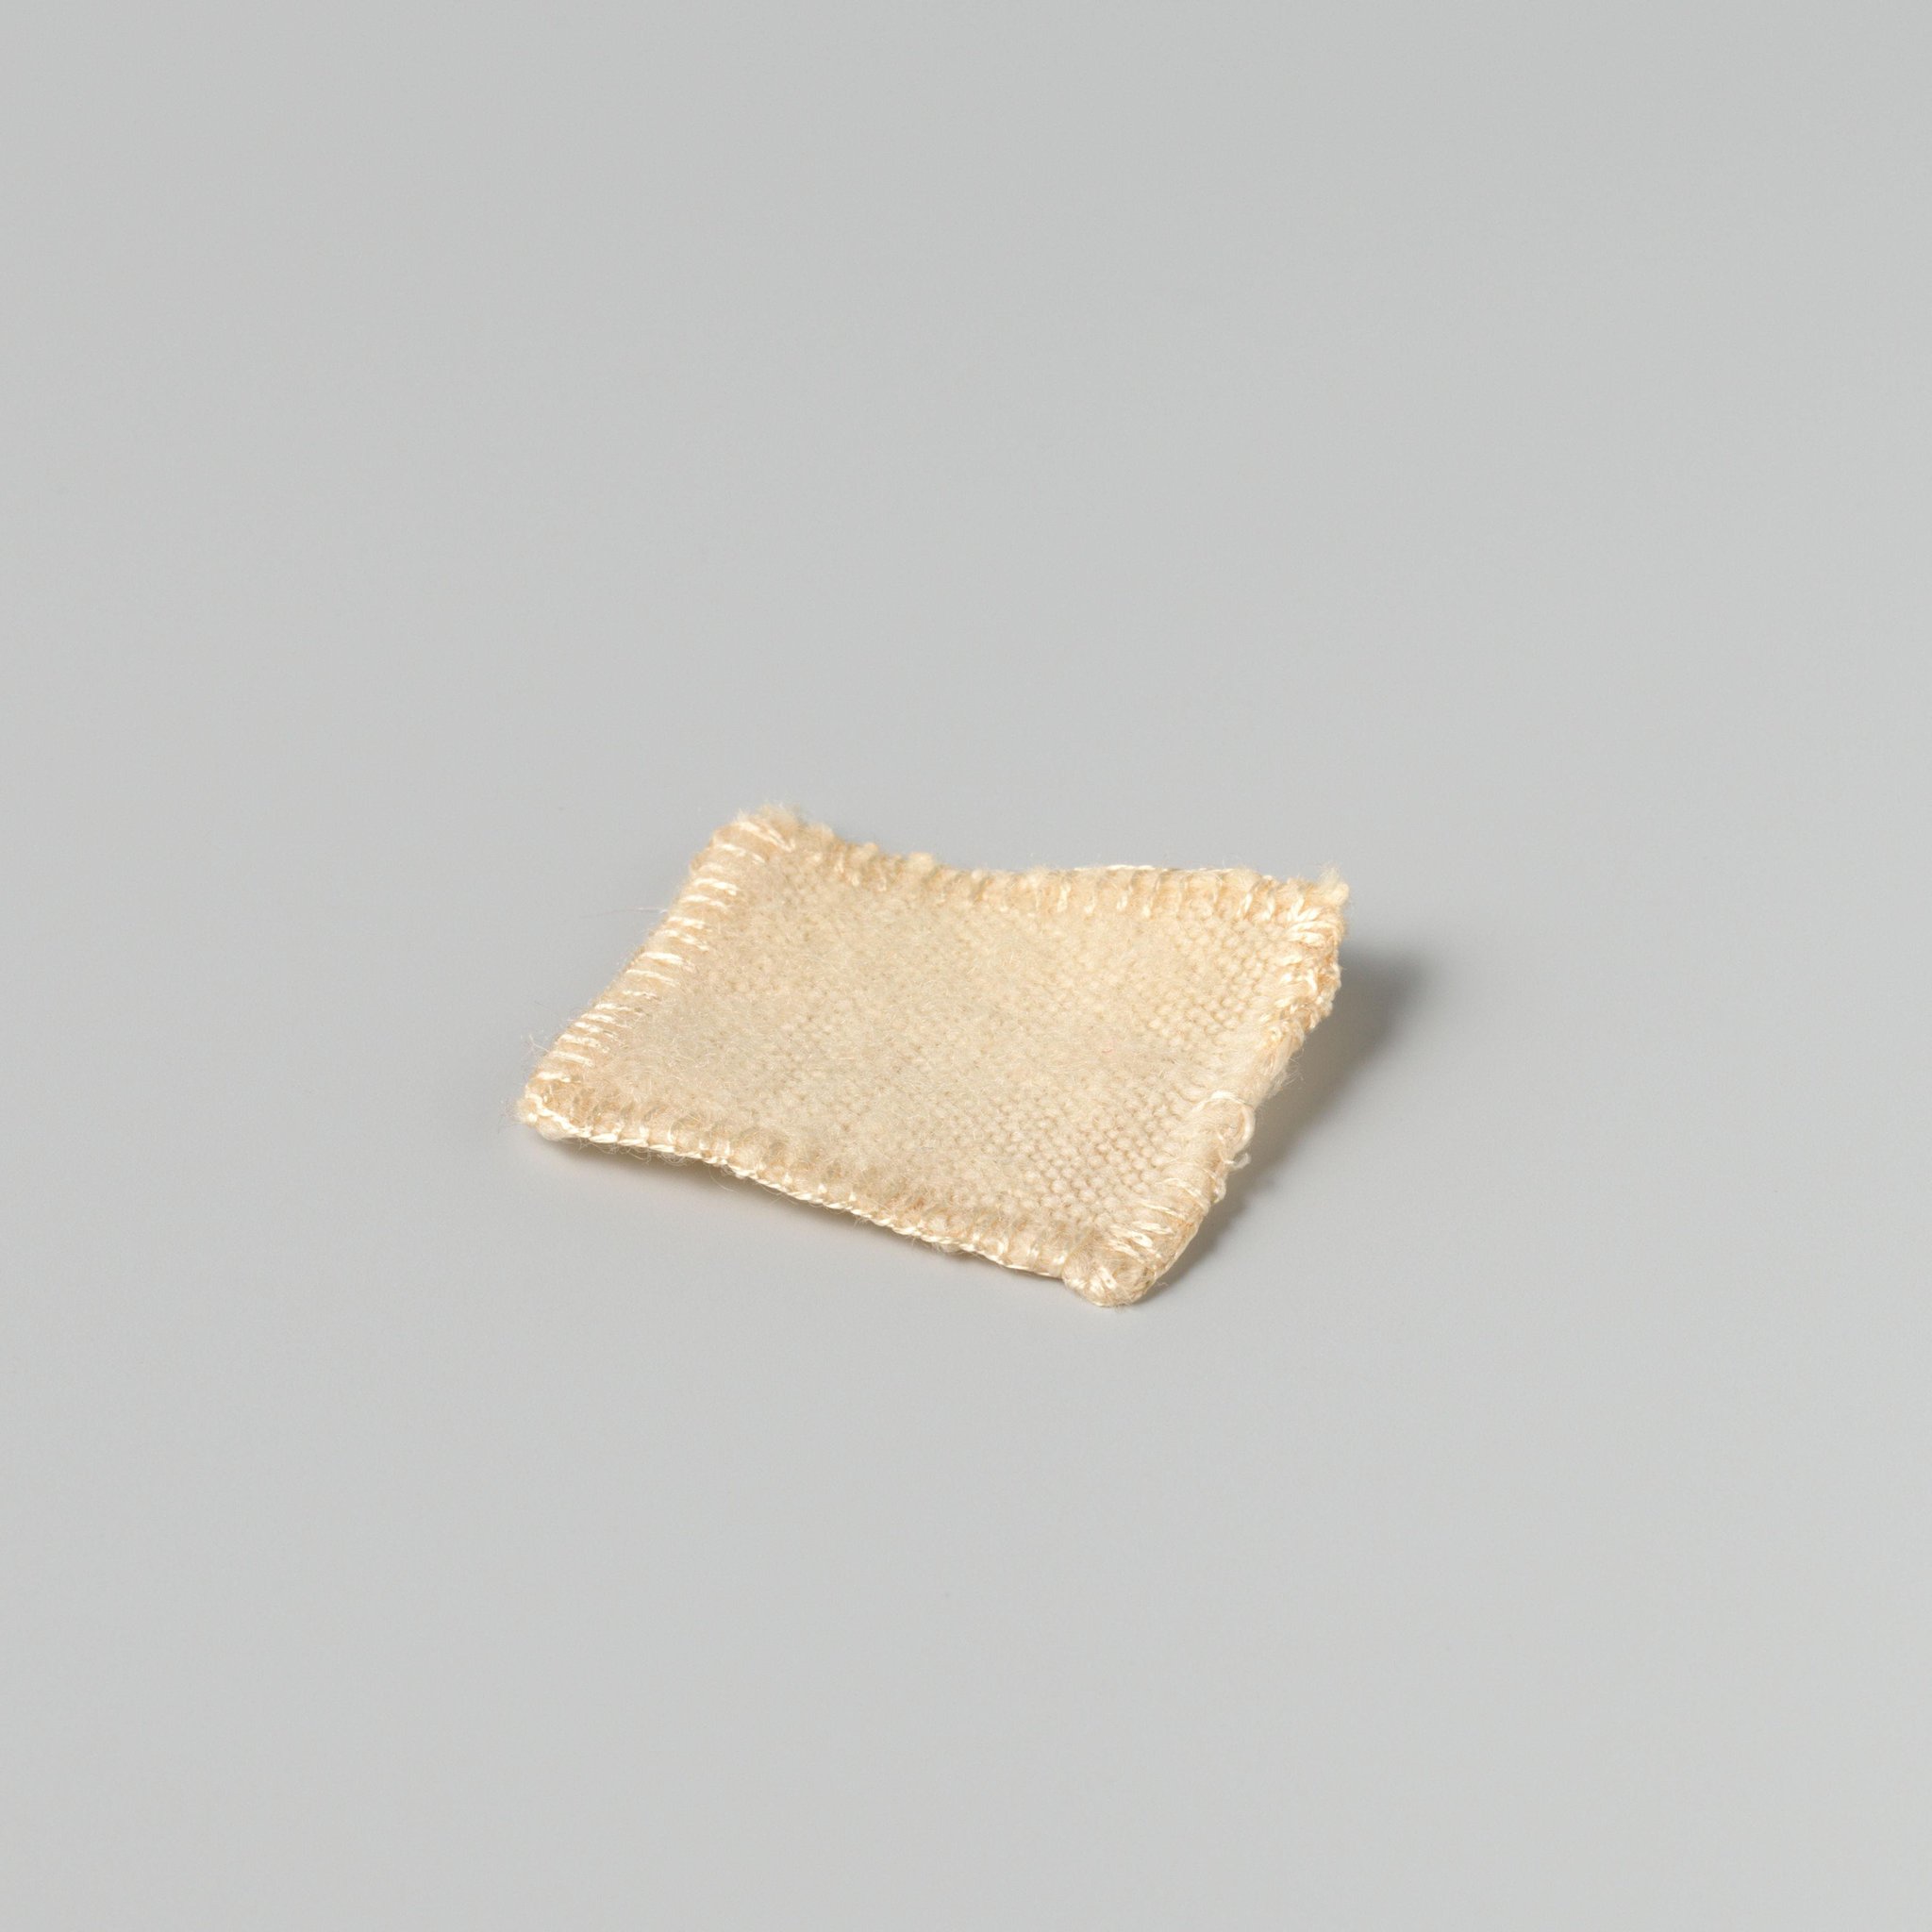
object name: diaper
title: Doek of luier van geruwde witte wol, afgezet met zijden draad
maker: Anonymous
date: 1676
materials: silk, wool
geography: netherlands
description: Doek of luier van geruwde witte wol, afgezet met zijden draad in festoneersteek